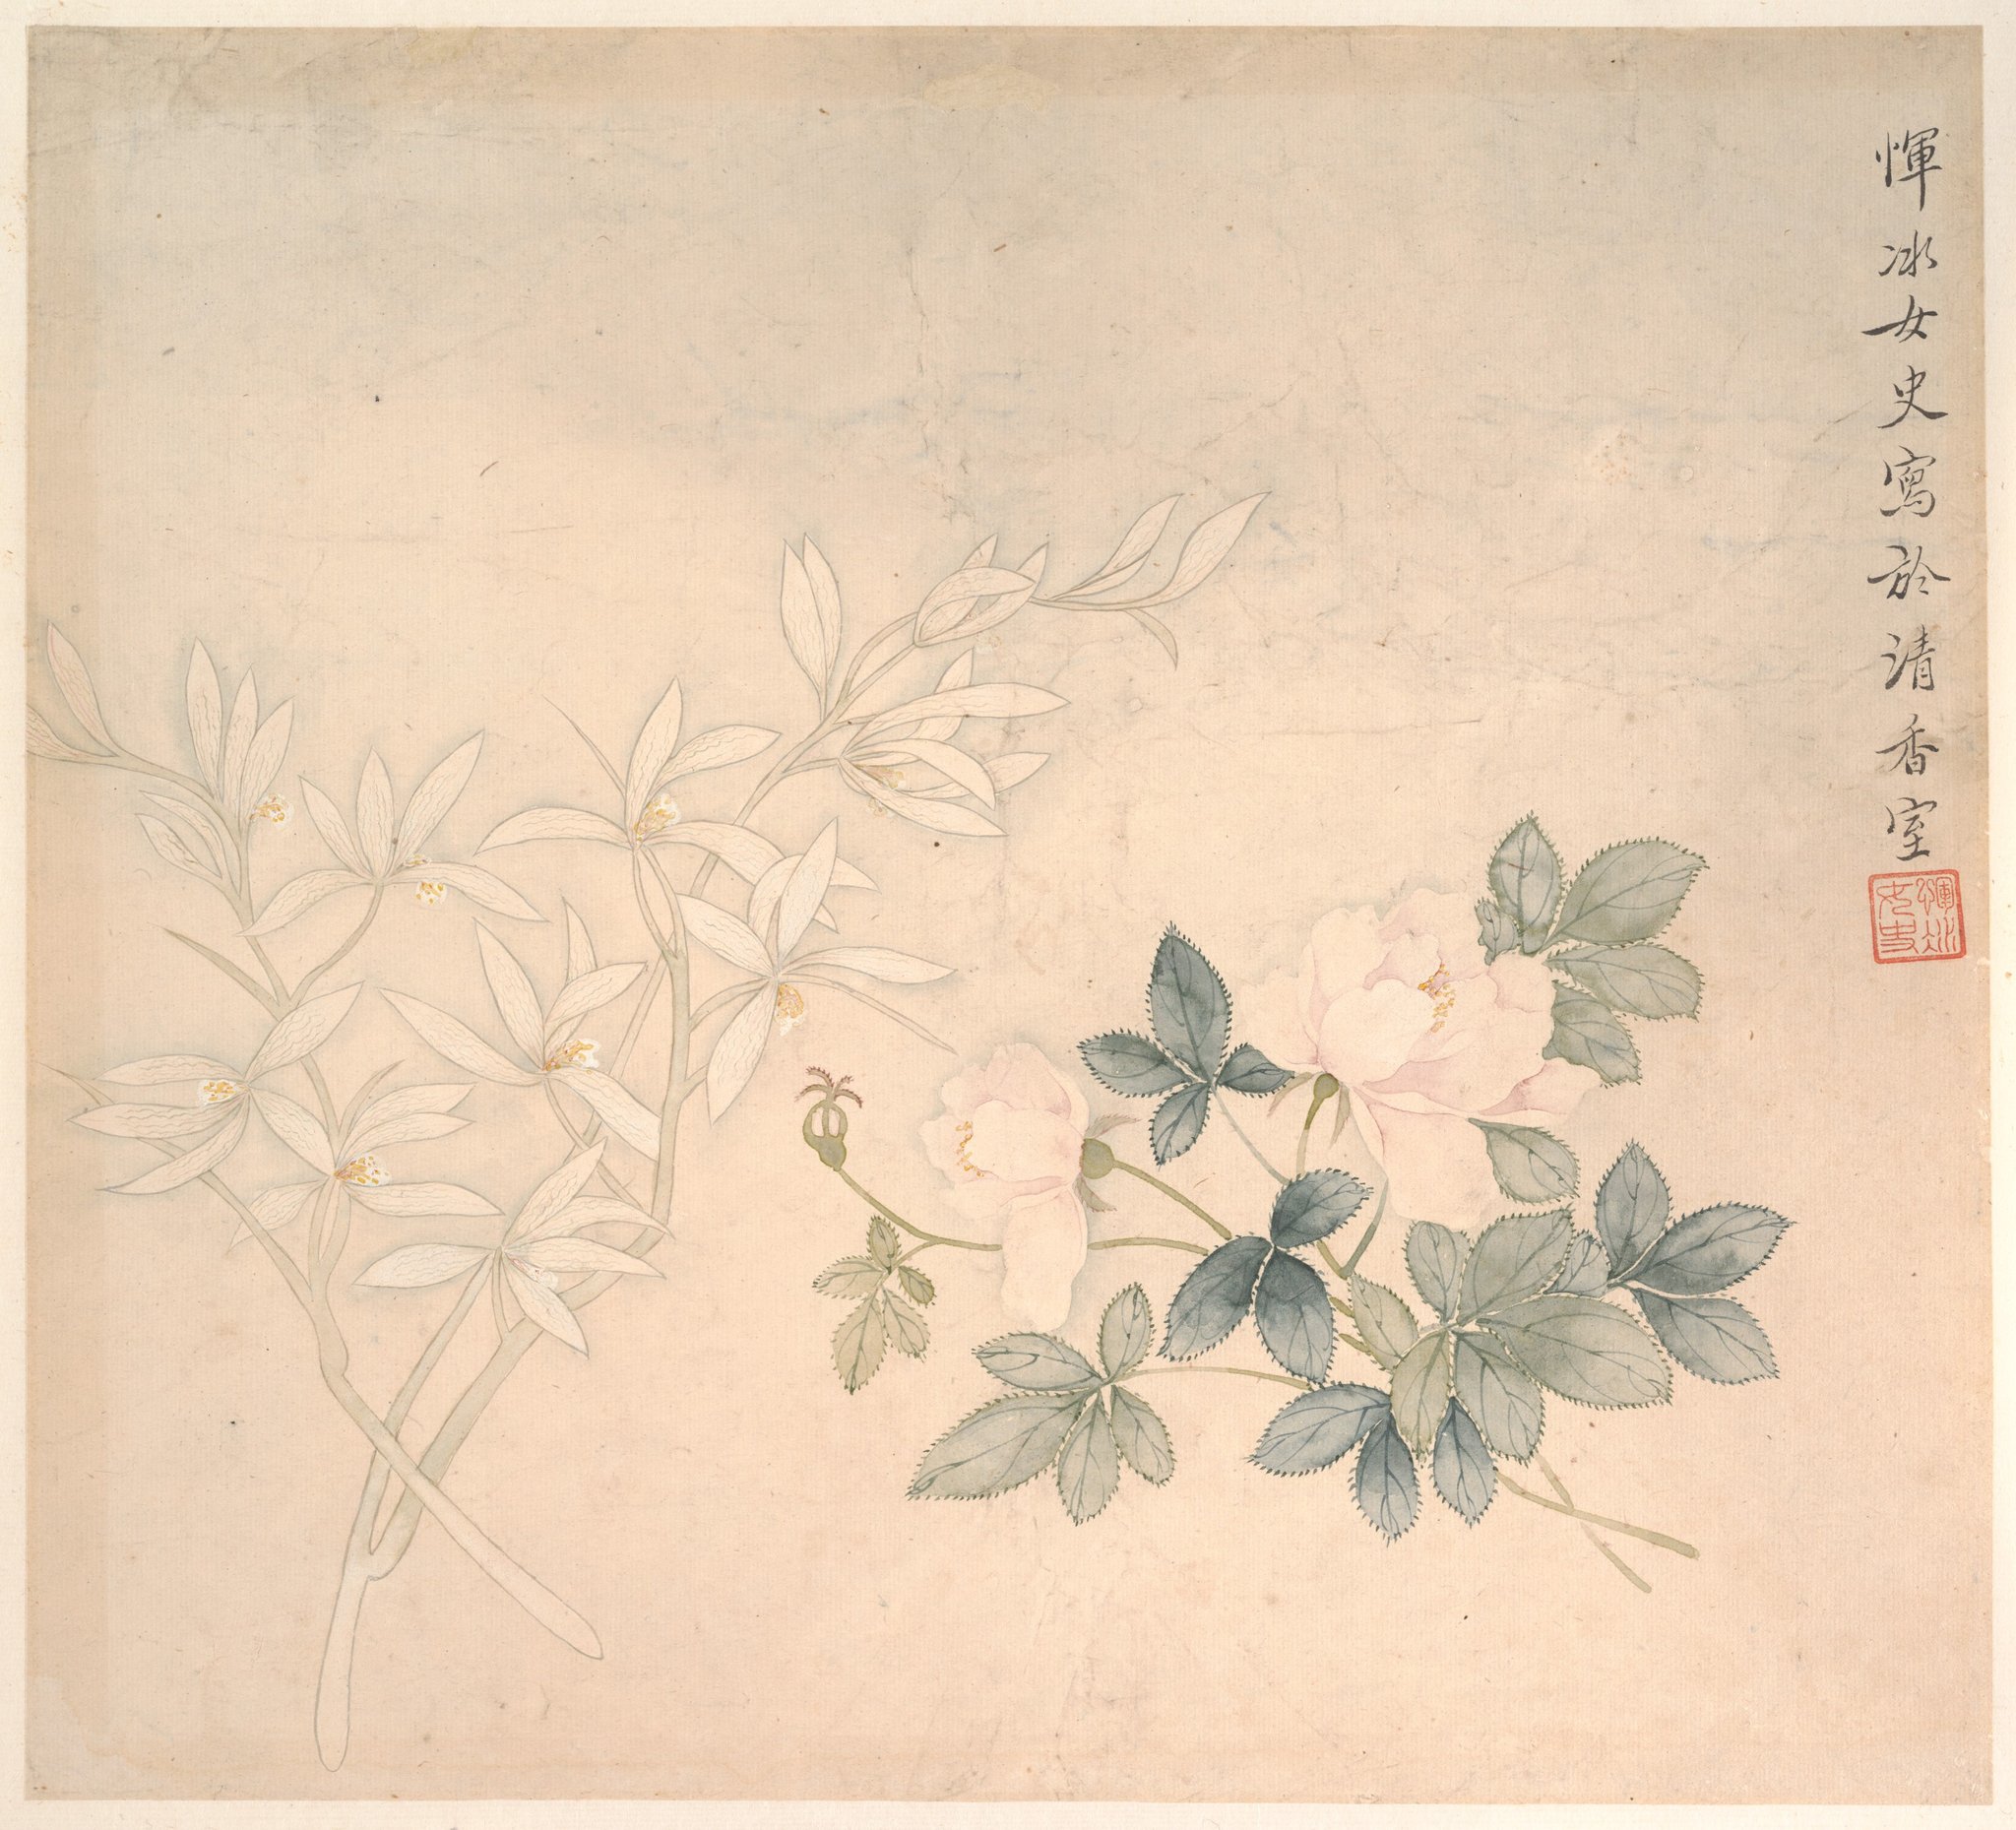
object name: album leaf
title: Flower Study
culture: chinese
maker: yun bing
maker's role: artist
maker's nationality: chinese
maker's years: 1650-1750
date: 1601-1700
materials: ink, paper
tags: flowers